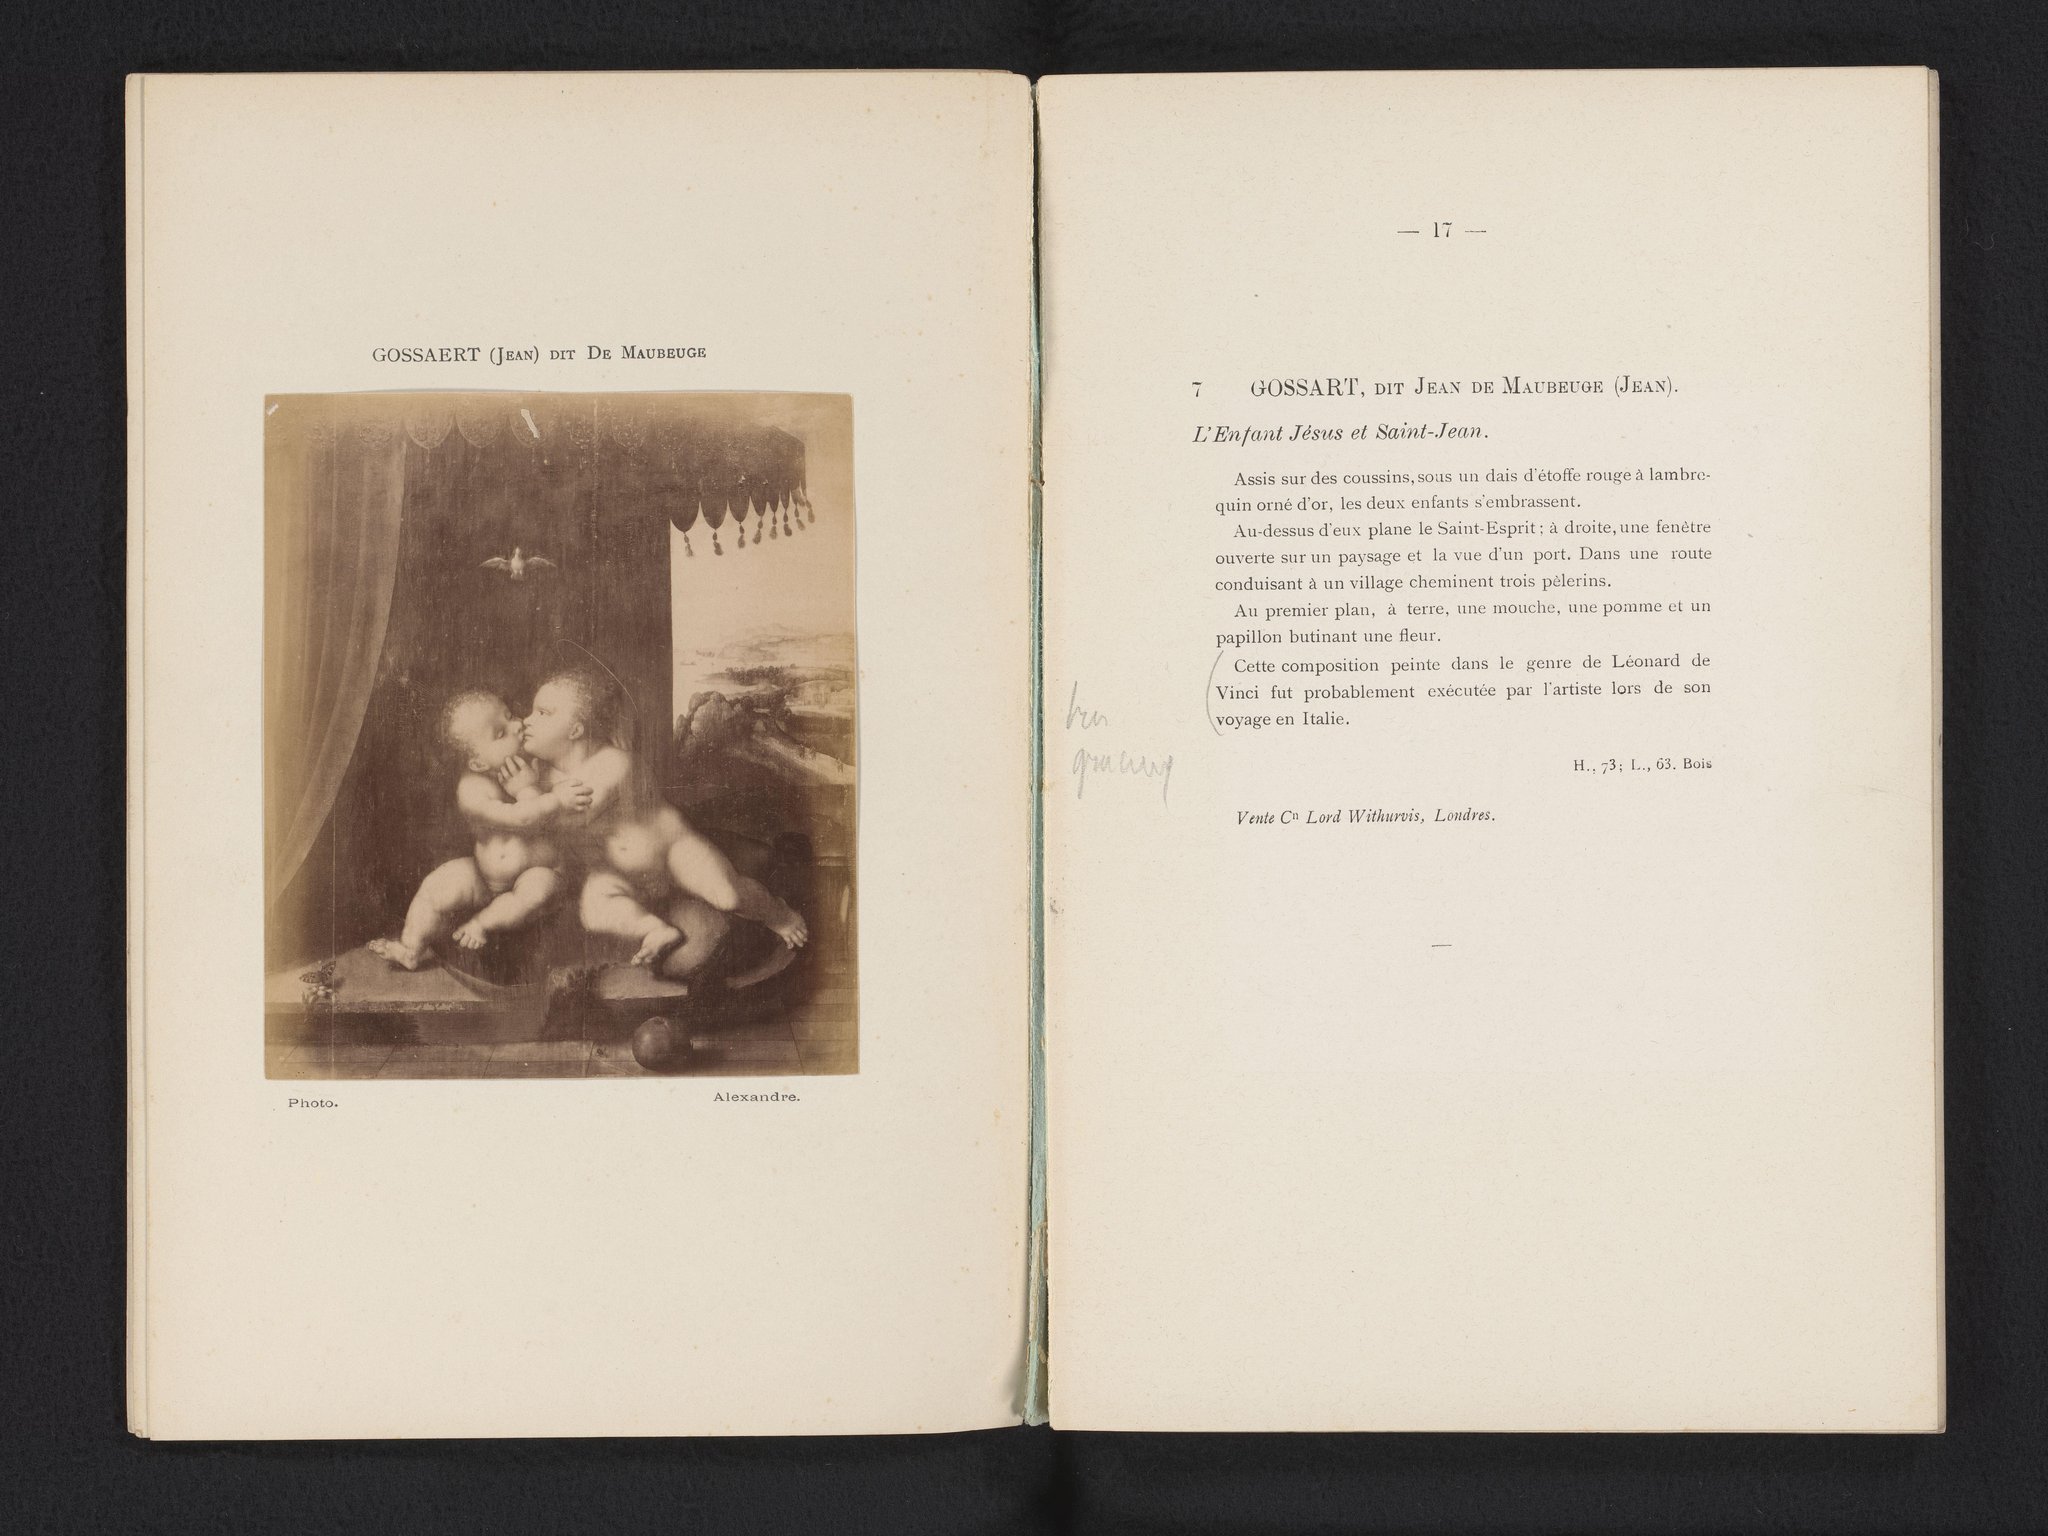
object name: photograph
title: Fotoreproductie van een schilderij van Christus en Johannes de Doper als kinderen door Joos van Cleve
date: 1878-1883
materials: photographic support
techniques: albumen print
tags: embracing each other, kissing, christ as youth, series of scenes from the life of john the baptist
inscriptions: inscription: ‘Gossaert (Jean) dit de Maubeuge’